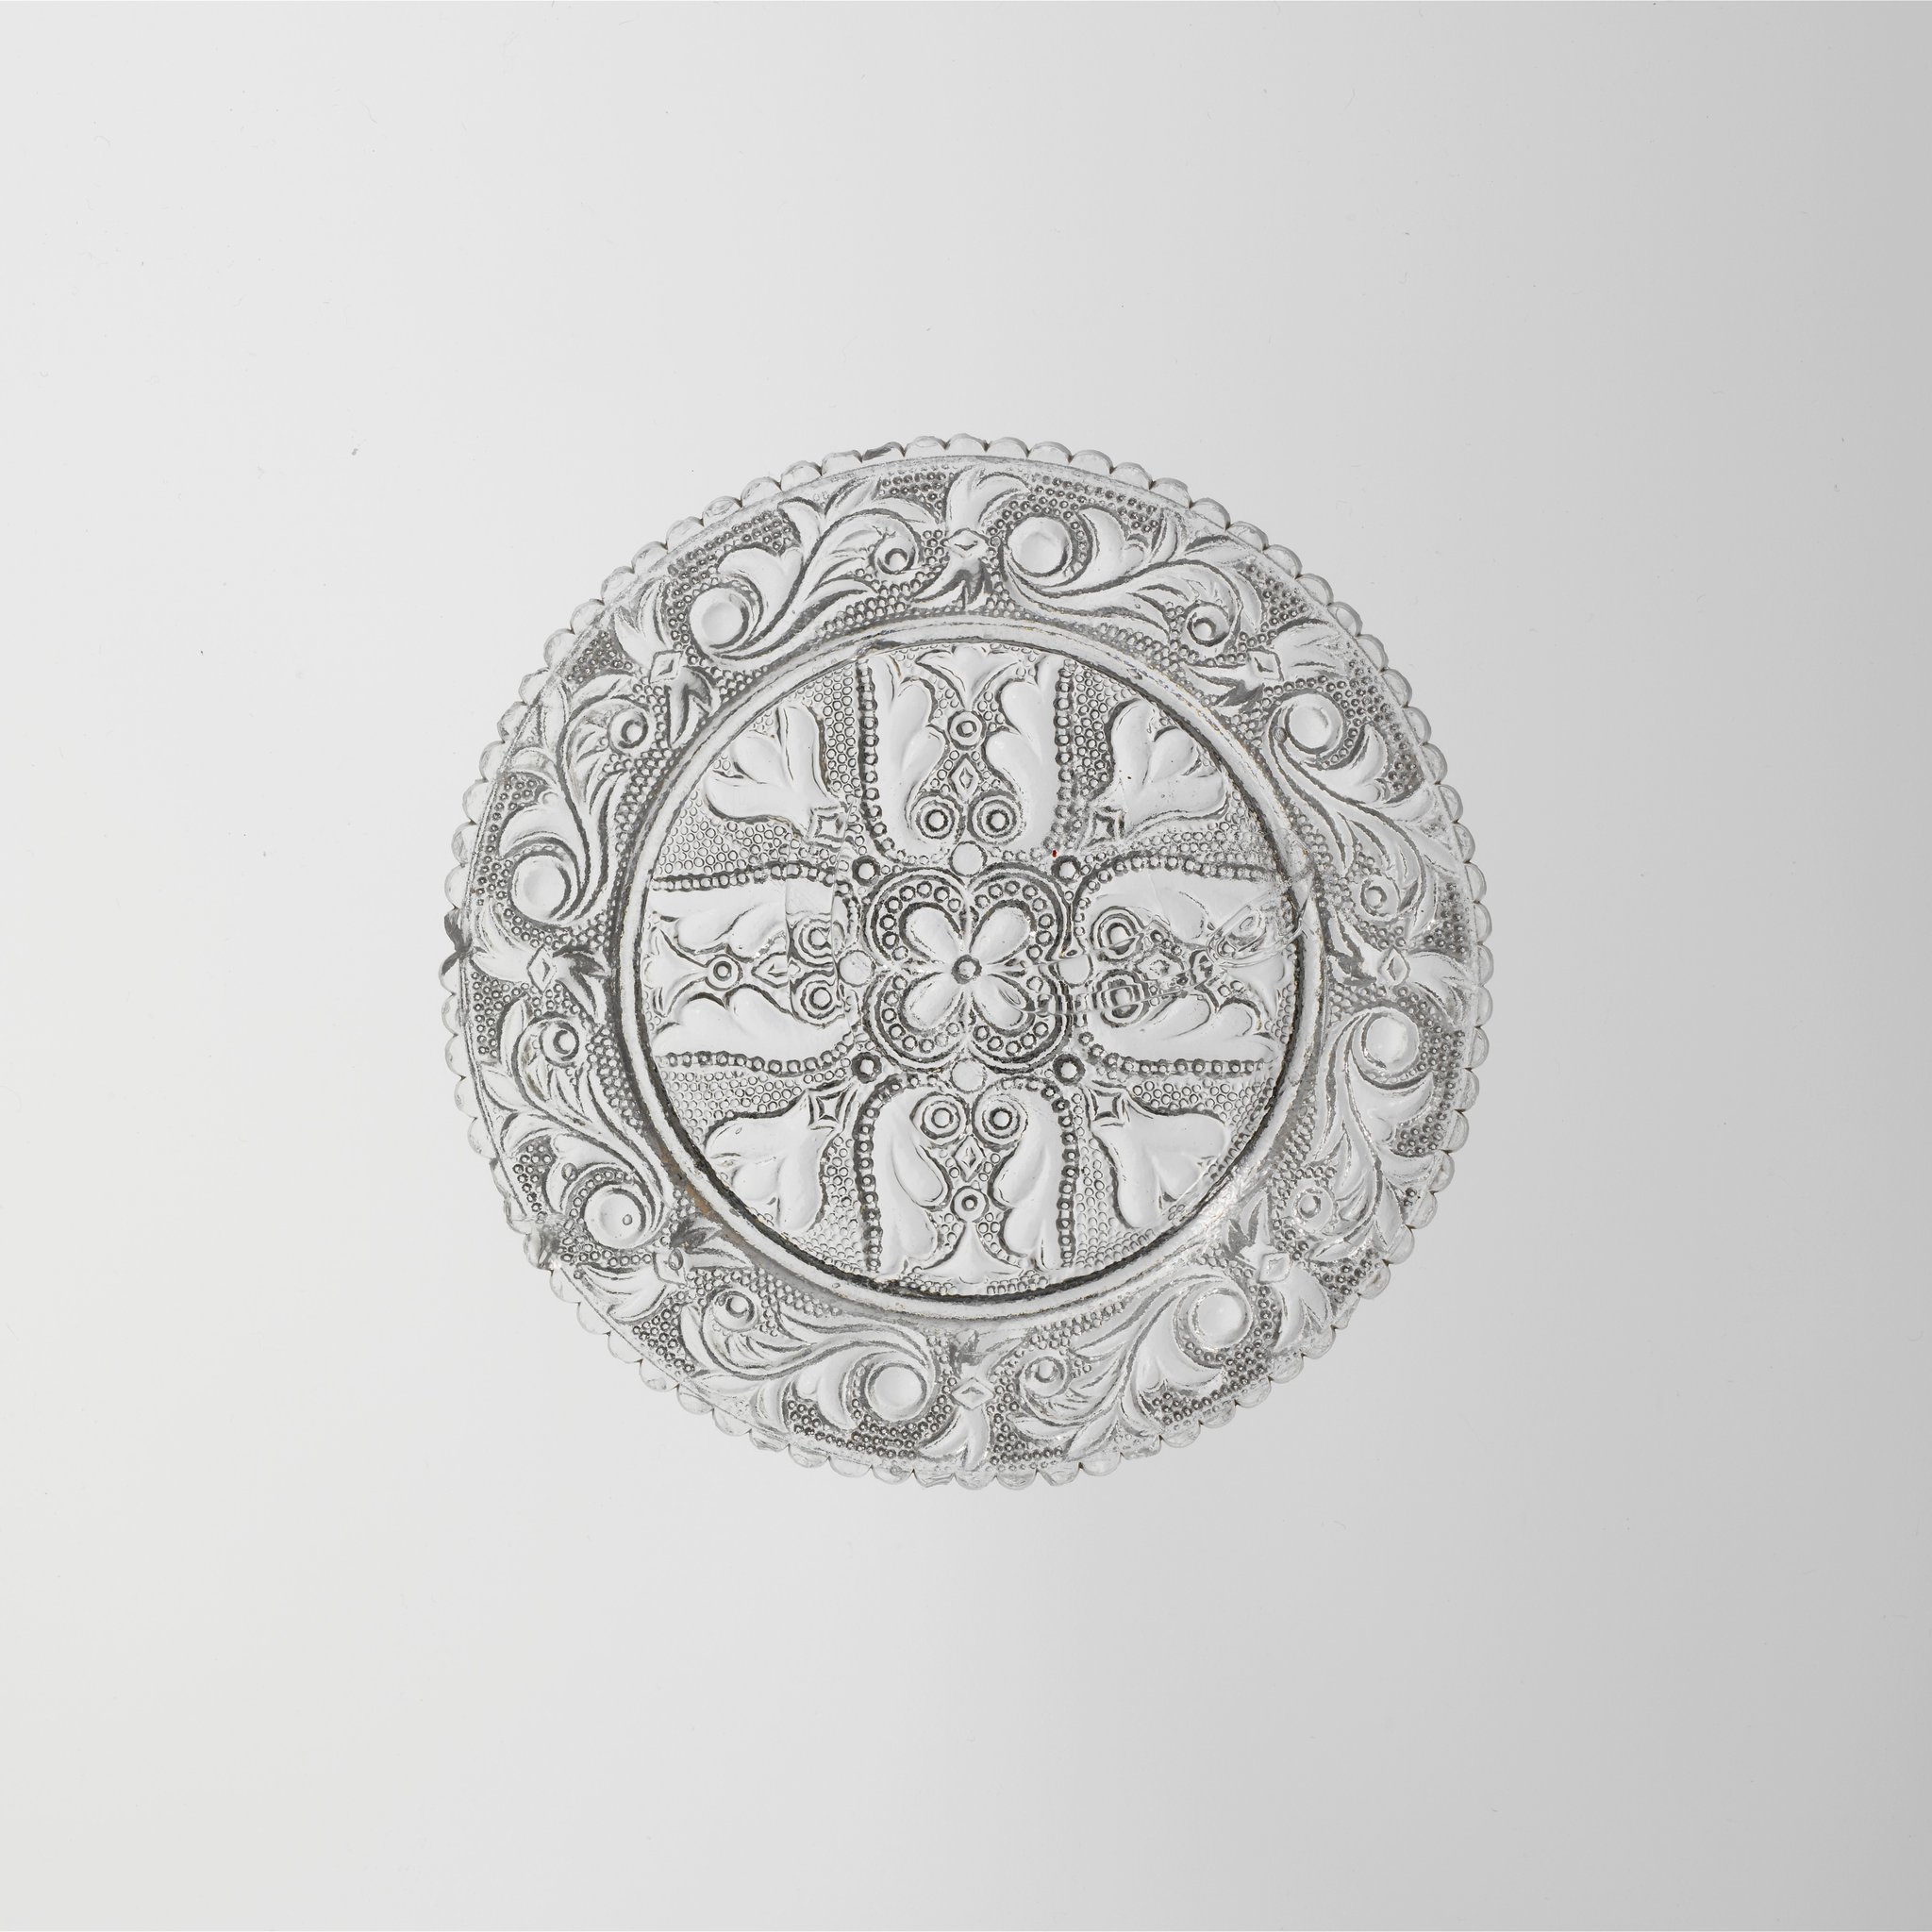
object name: cup plate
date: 1825-1860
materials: glass